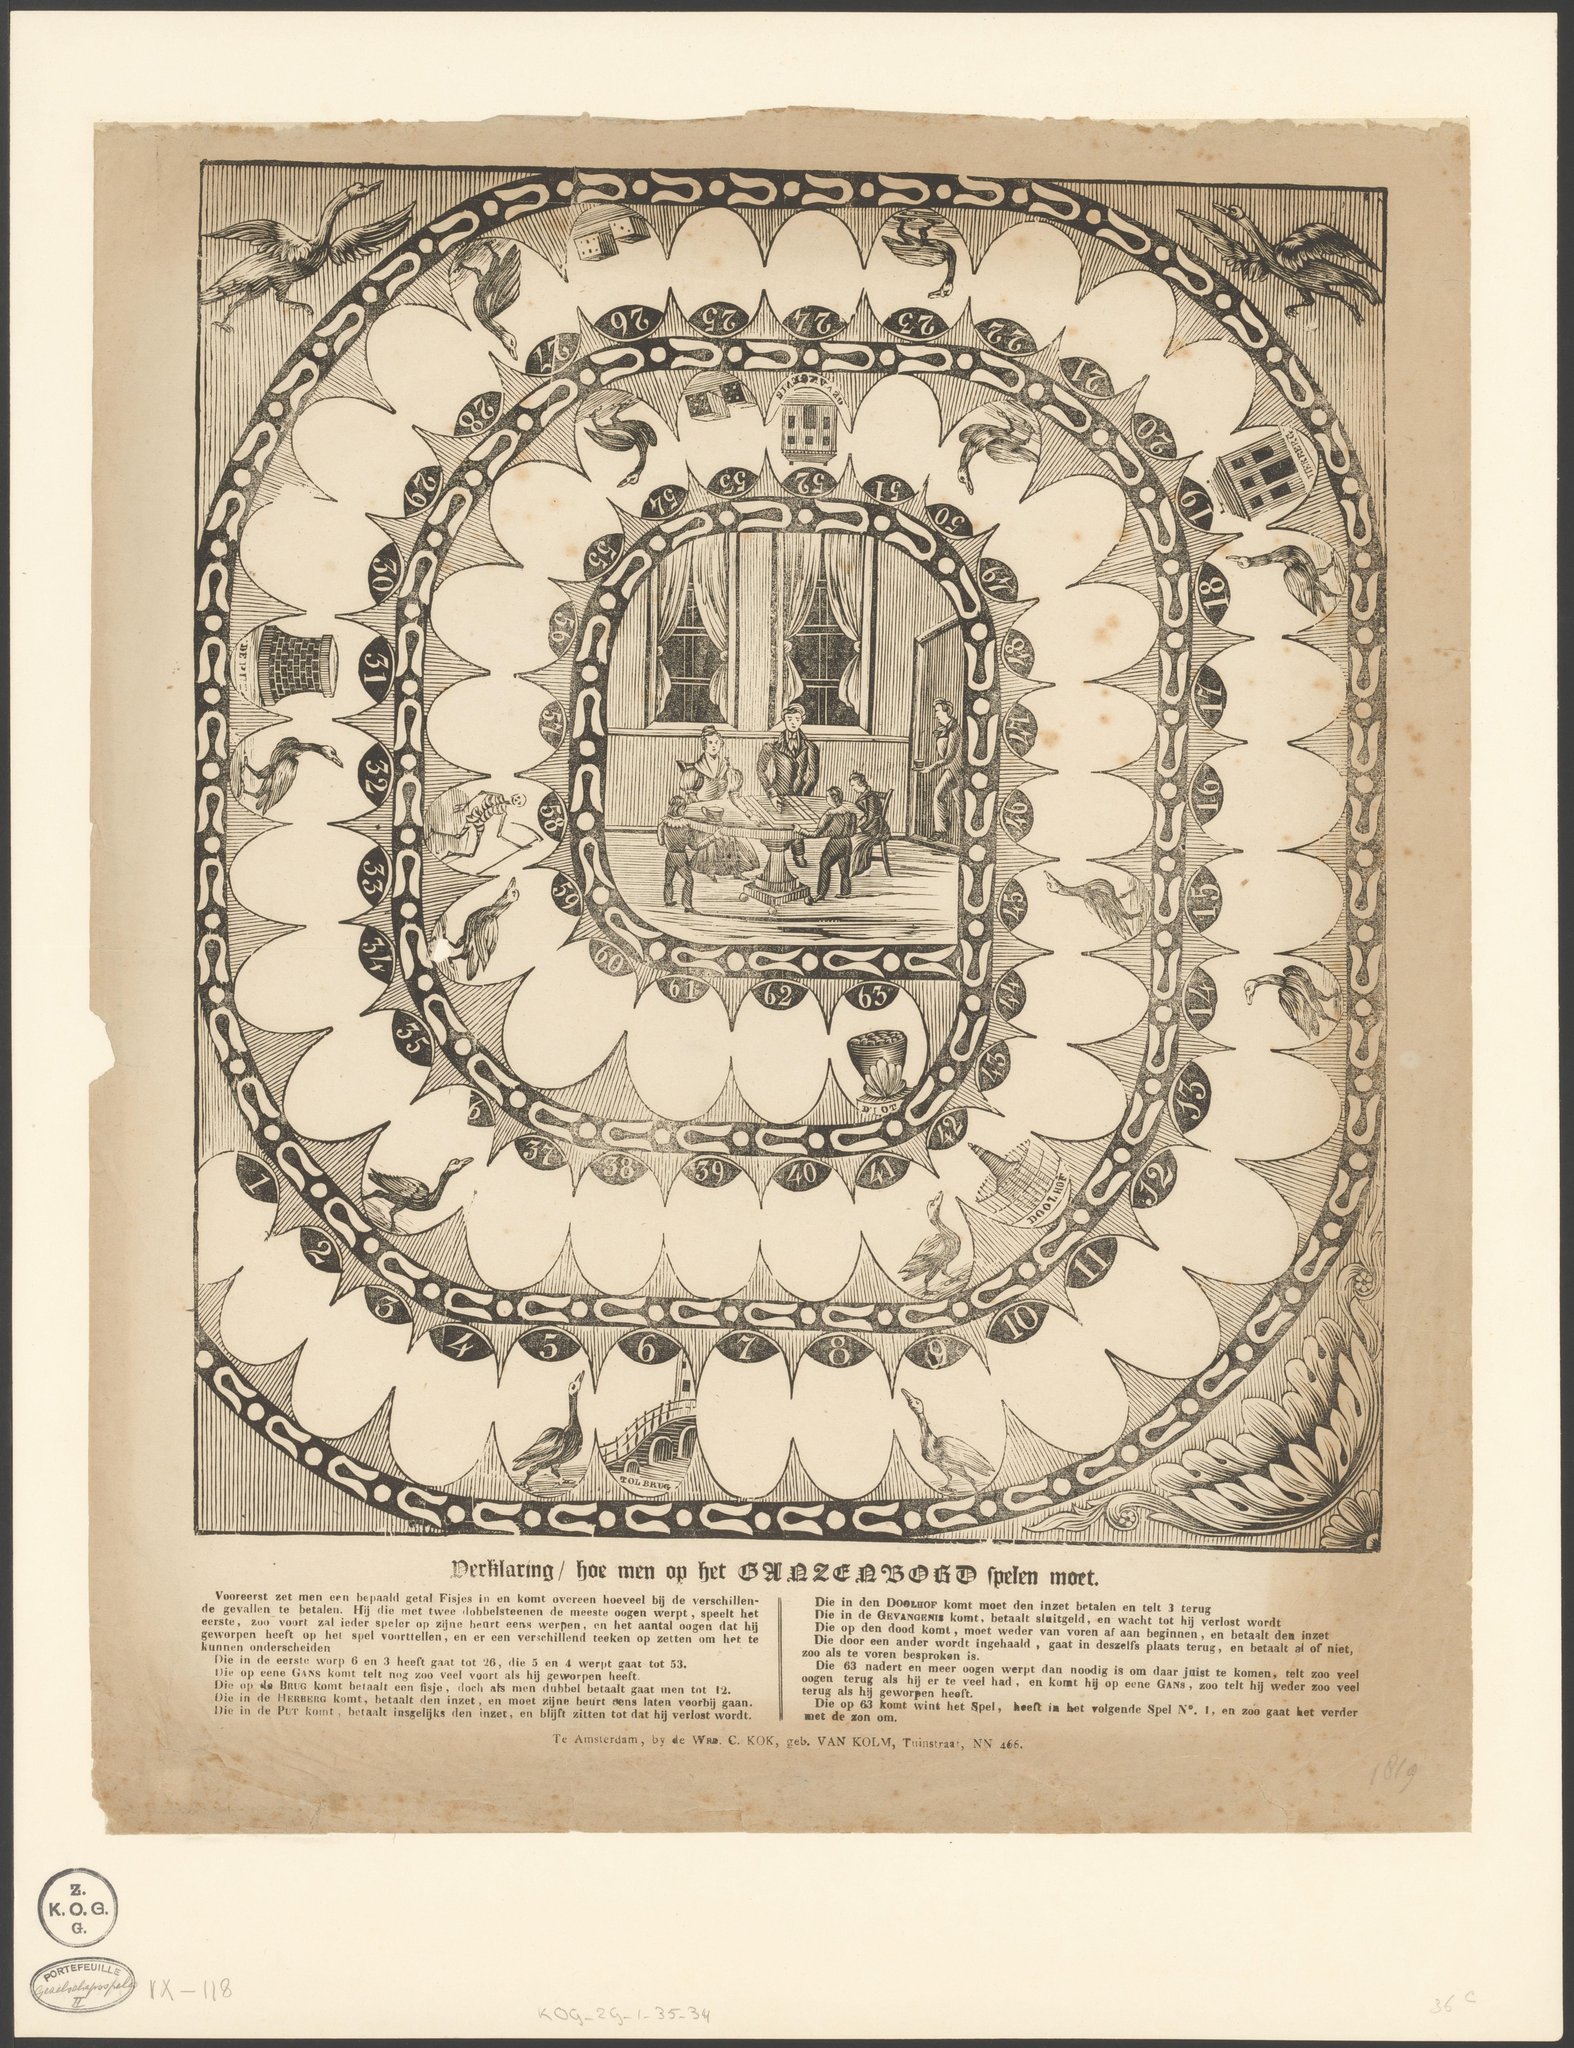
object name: print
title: Verklaring / hoe men op het Ganzenbord spelen moet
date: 1839-1851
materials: paper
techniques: letterpress printing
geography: amsterdam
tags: water-birds: goose, board-games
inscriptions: stamp, collector's mark: Lugt 1641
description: Bordspel met 63 vakken met in het midden een afbeelding van een vader, een moeder en drie kinderen die om een tafel een spel spelen. In de deuropening een man met een kop in zijn hand. Onder het spel de spelregels. Onderwerpsrubrieken binnen de Atlas Zeden en Gewoonten: Zeden en gewoonten in engeren zin, Spel en vermaak, Gezelschapsspel II, Ganzenbord en dergelijke.